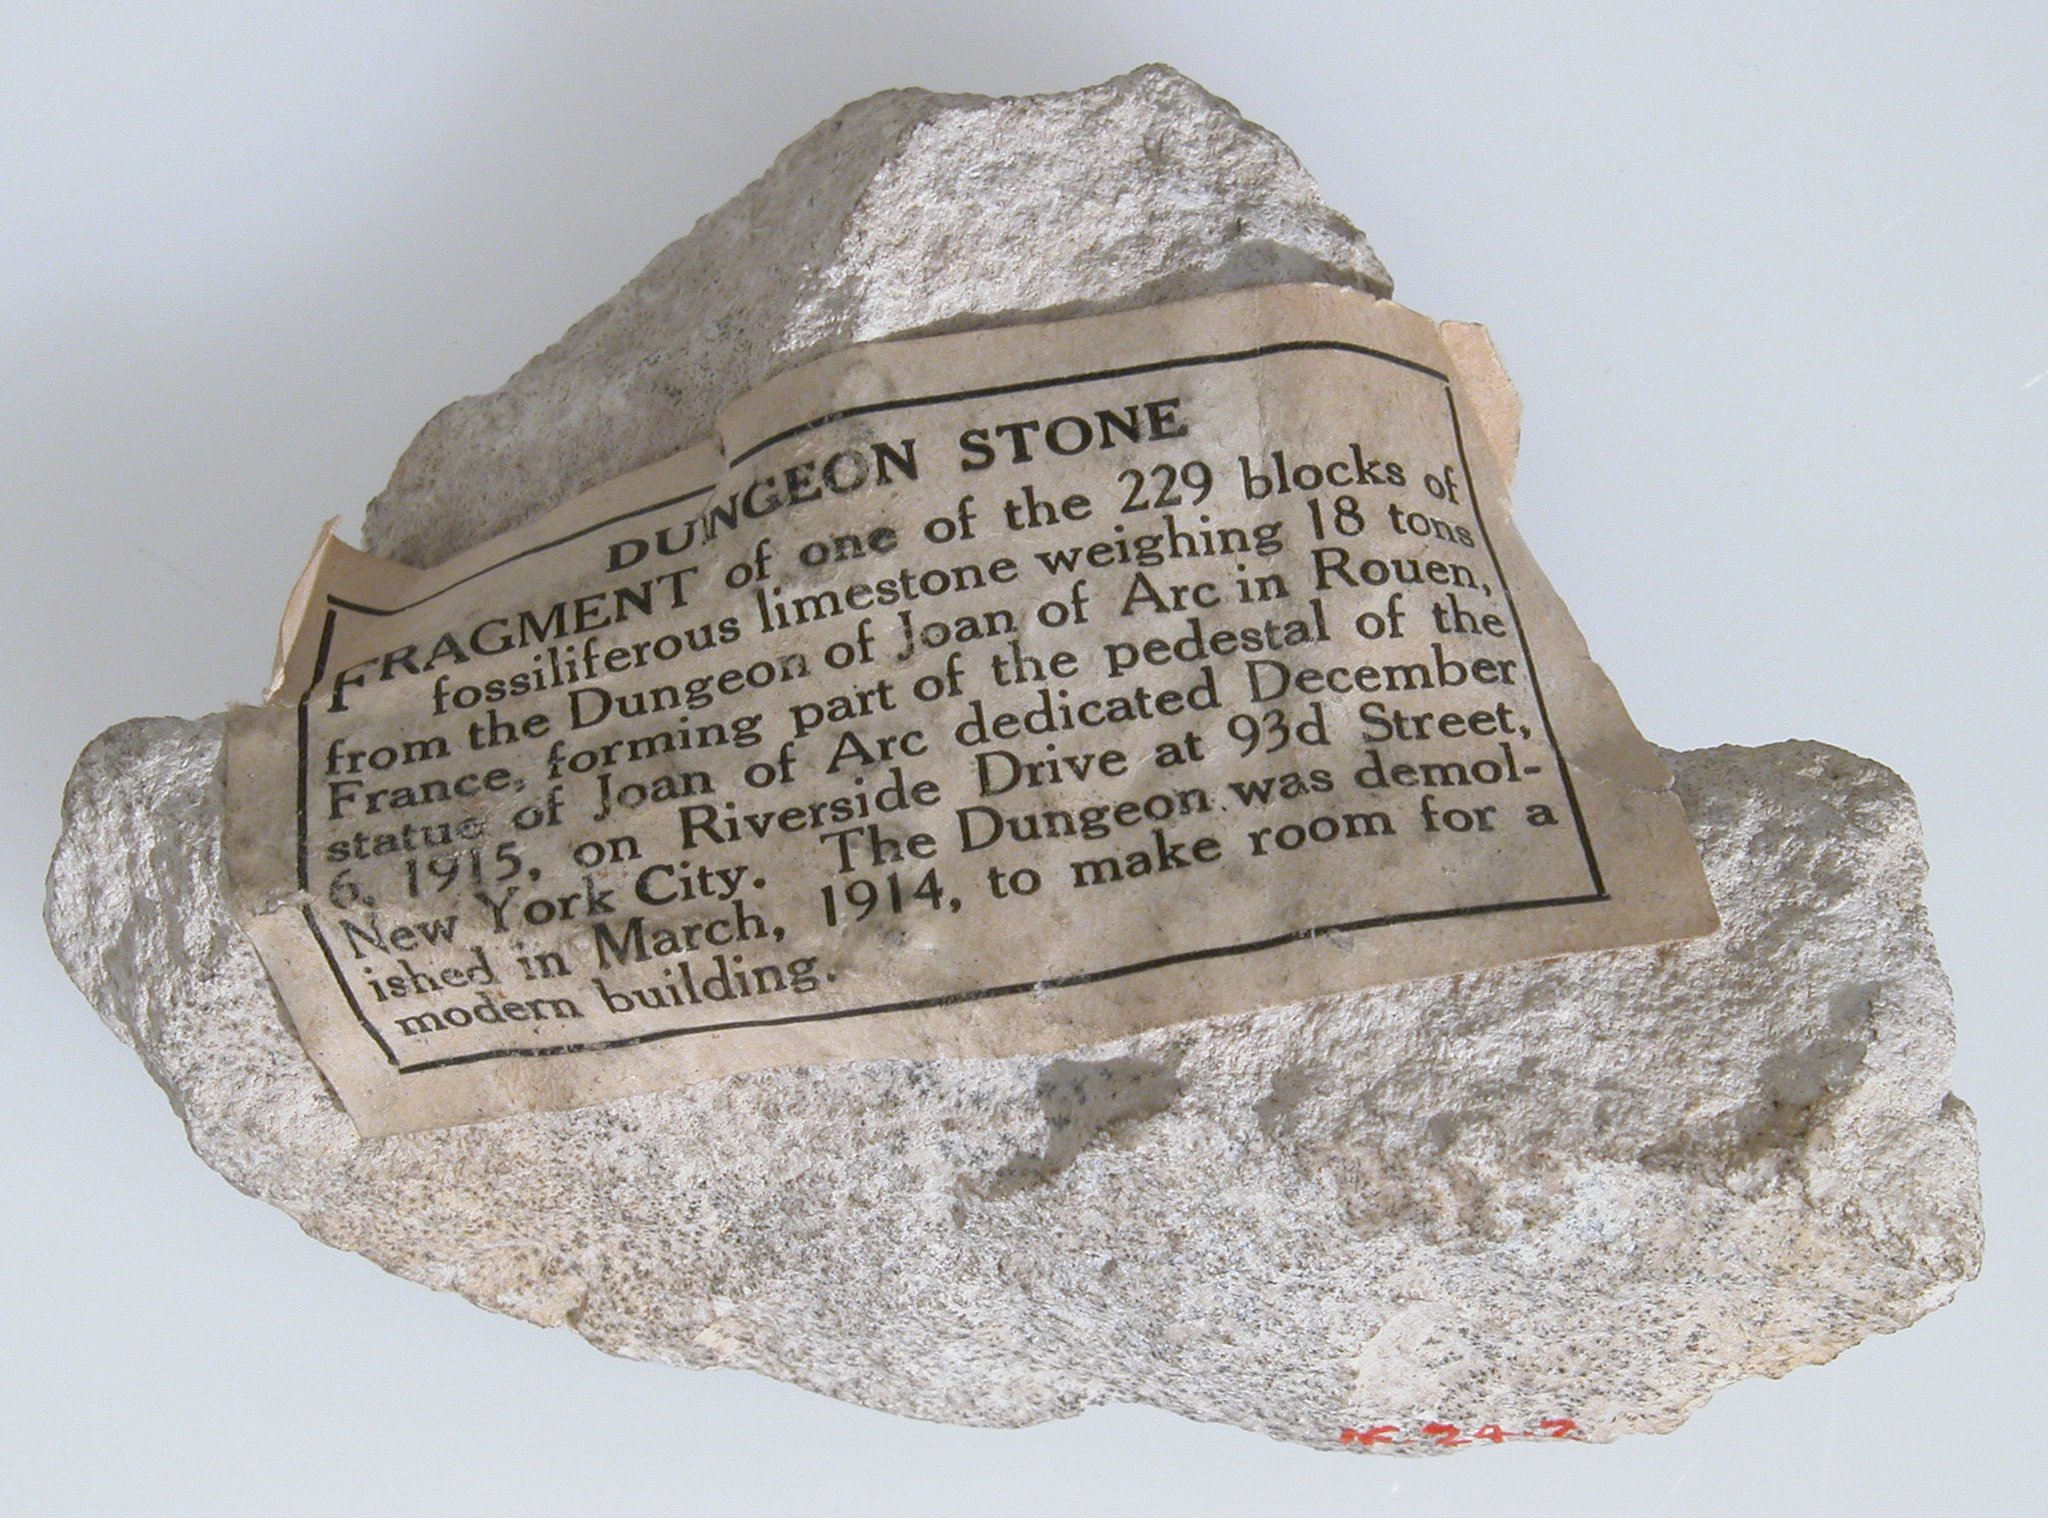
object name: fragment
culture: french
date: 1412-1431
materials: limestone